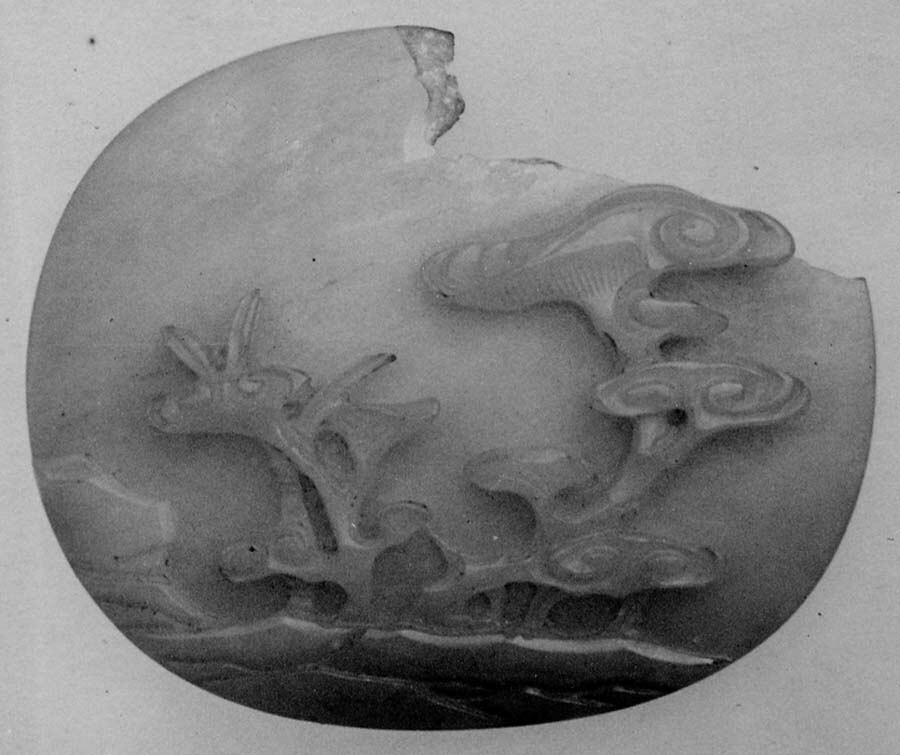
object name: fragment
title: Fragment of a Medallion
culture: chinese or turkestani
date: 1902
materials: jade